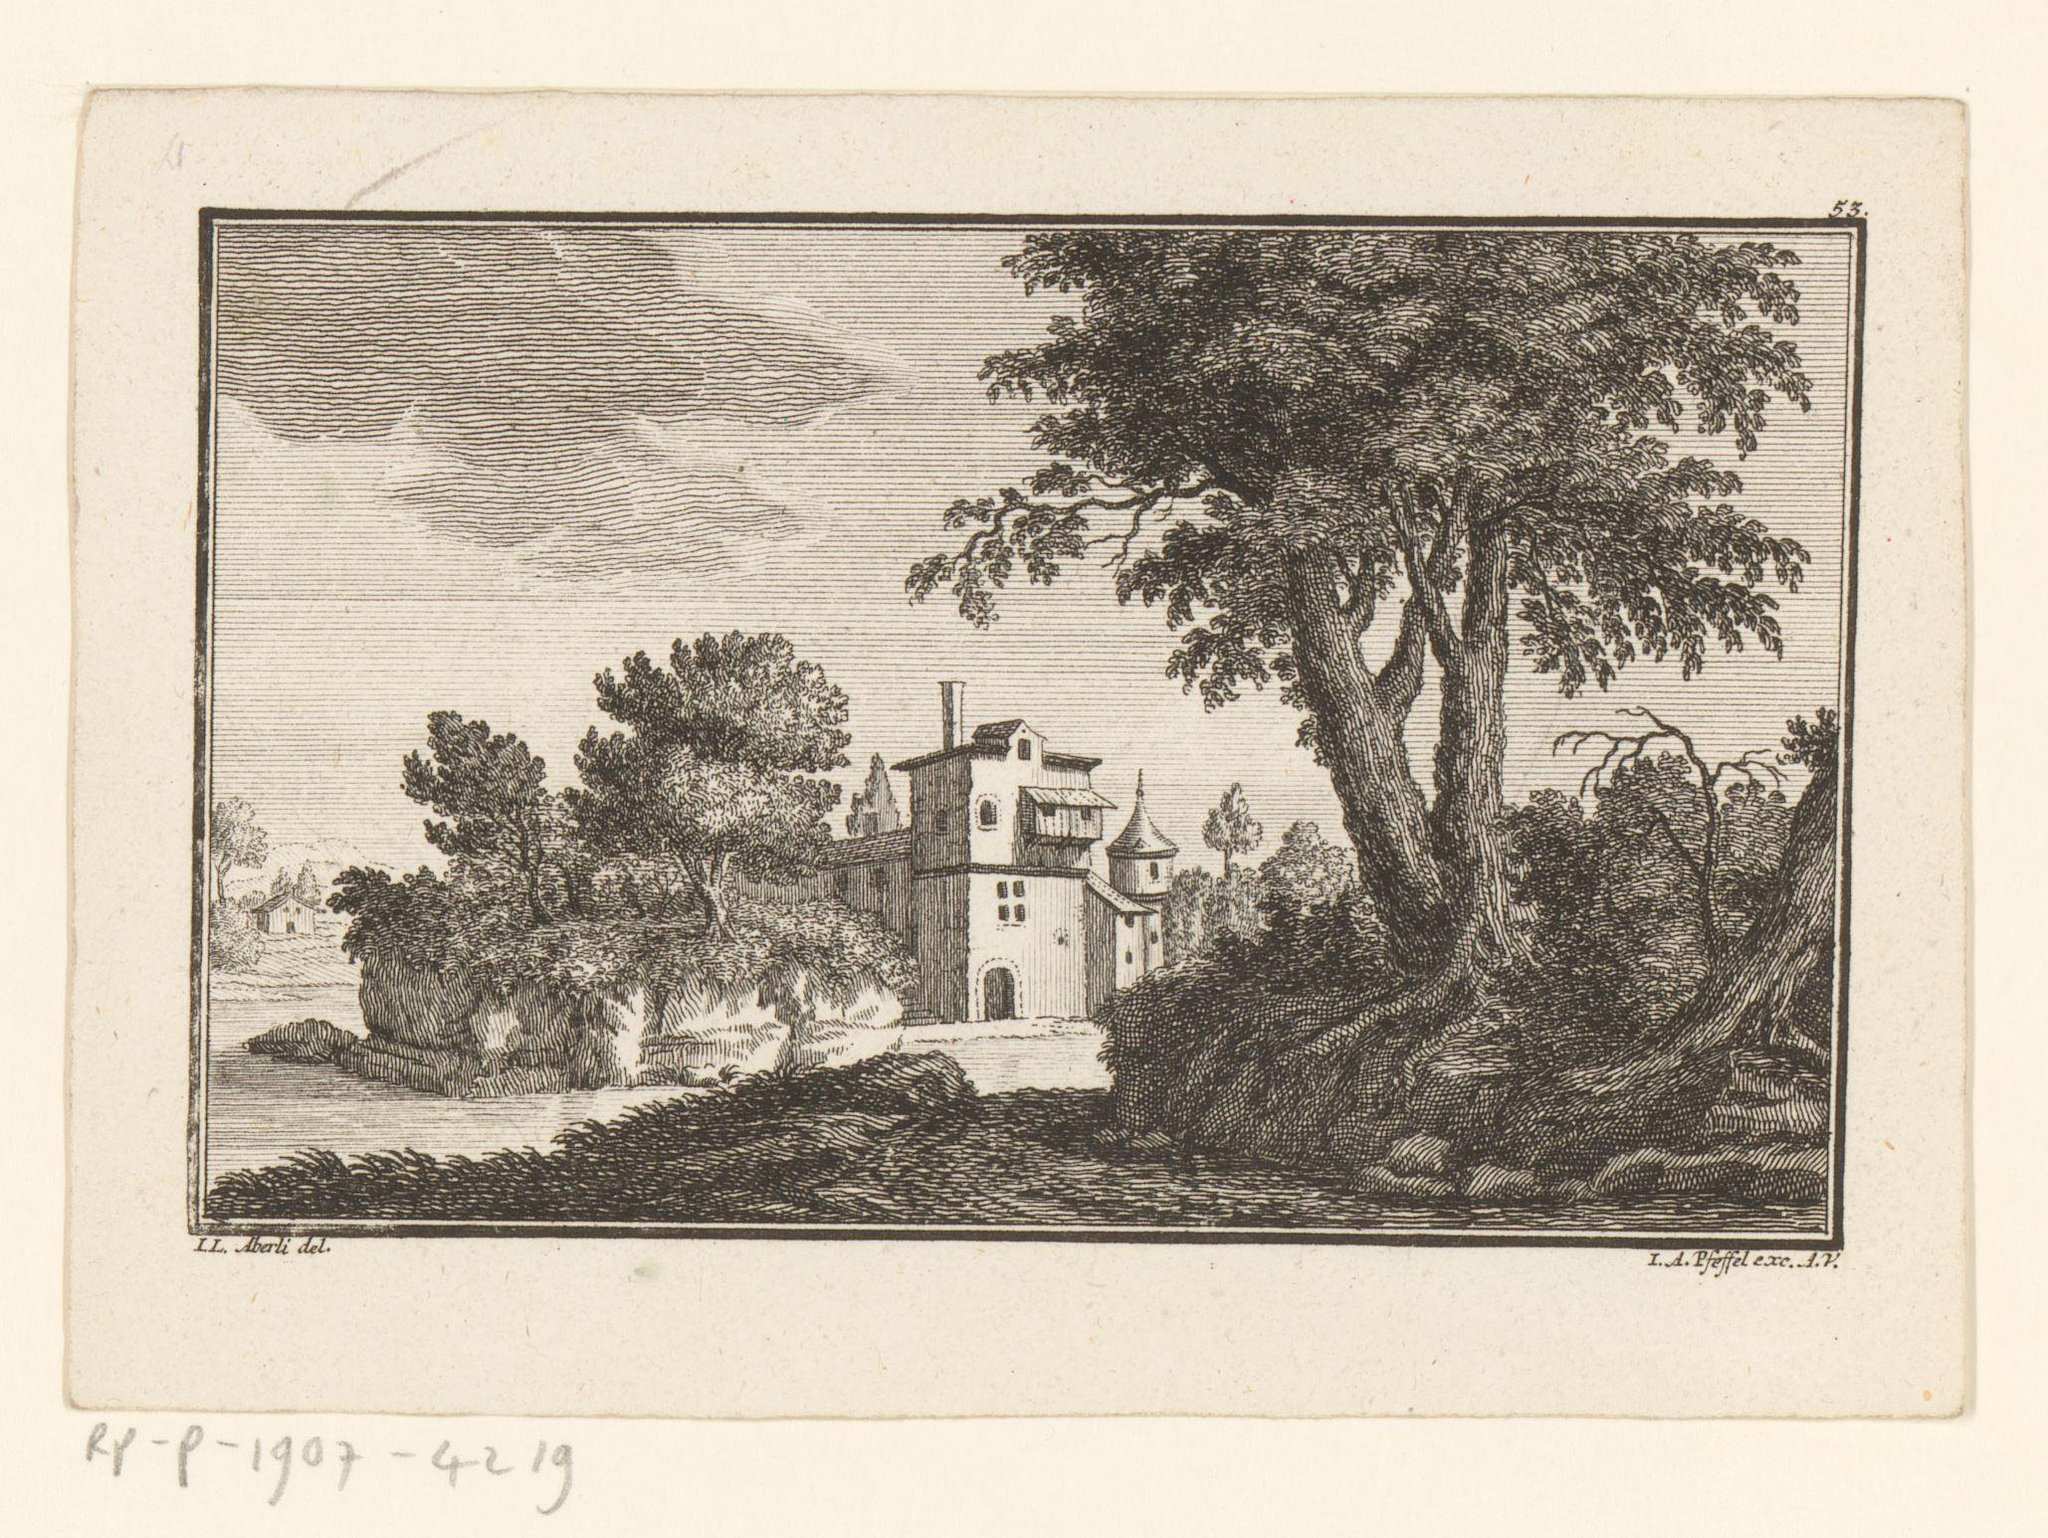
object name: print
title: Gezicht op een landhuis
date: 1725-1768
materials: paper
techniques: etching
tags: city-view, and landscape with man-made constructions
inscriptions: collector's mark: Lugt 2228